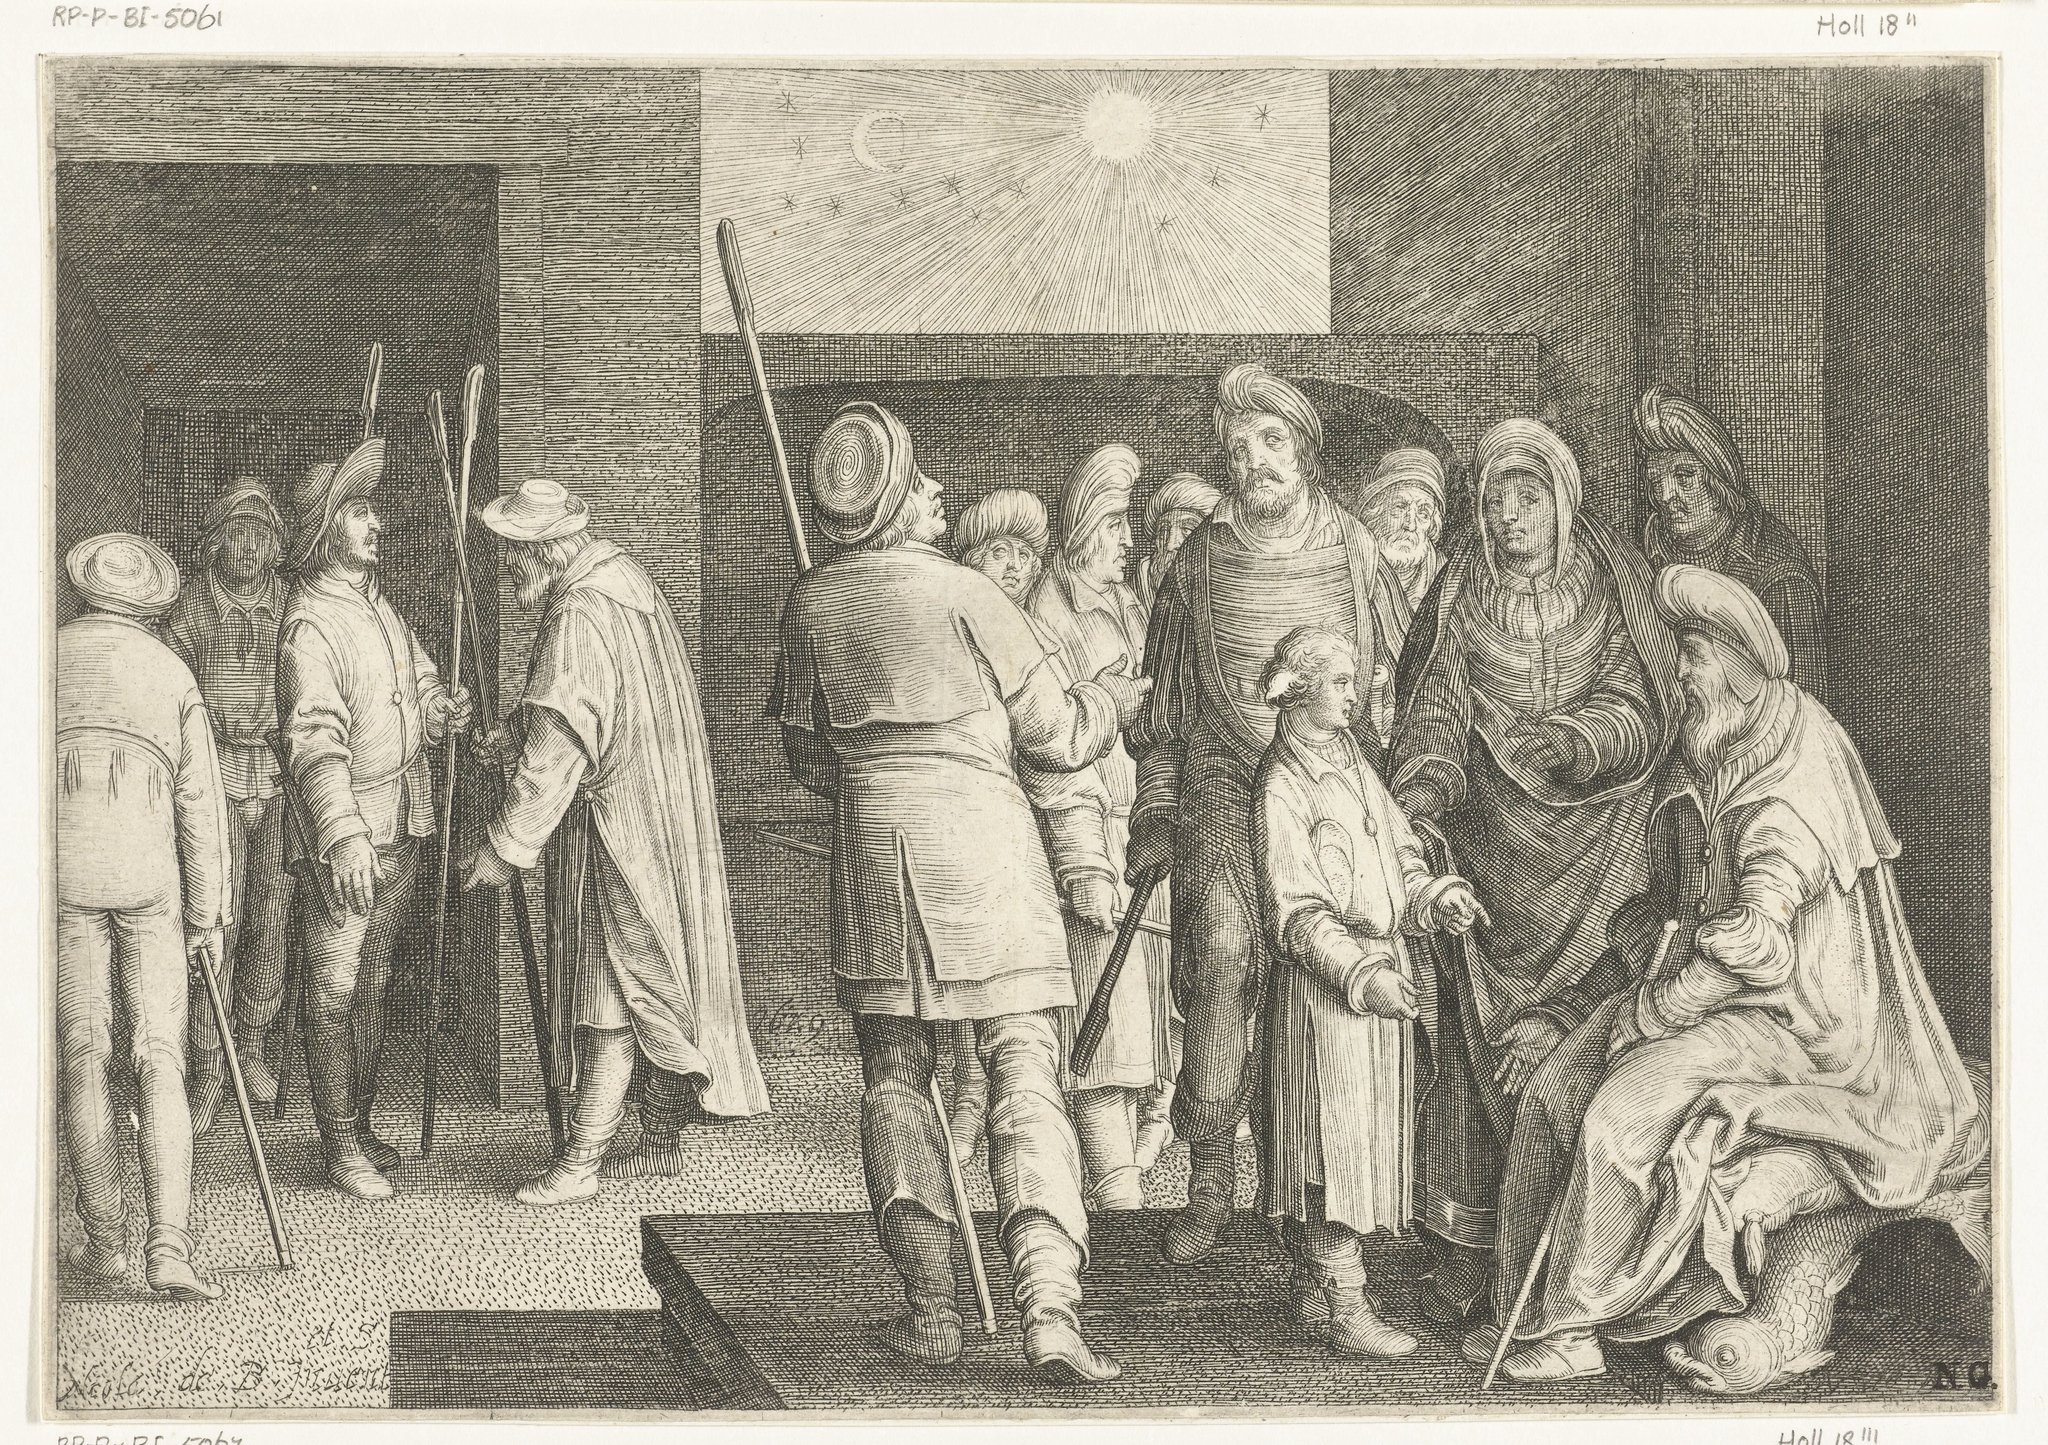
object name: print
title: Verhaal van Jozef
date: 1628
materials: paper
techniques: engraving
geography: netherlands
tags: joseph relates his first dream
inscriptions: collector's mark: Lugt 2228, collector's mark: Lugt 1967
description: Prent uit serie van zes prenten met het verhaal van Jozef. De serie is geïnspireerd op een vergelijkbare reeks van Lucas van Leyden.